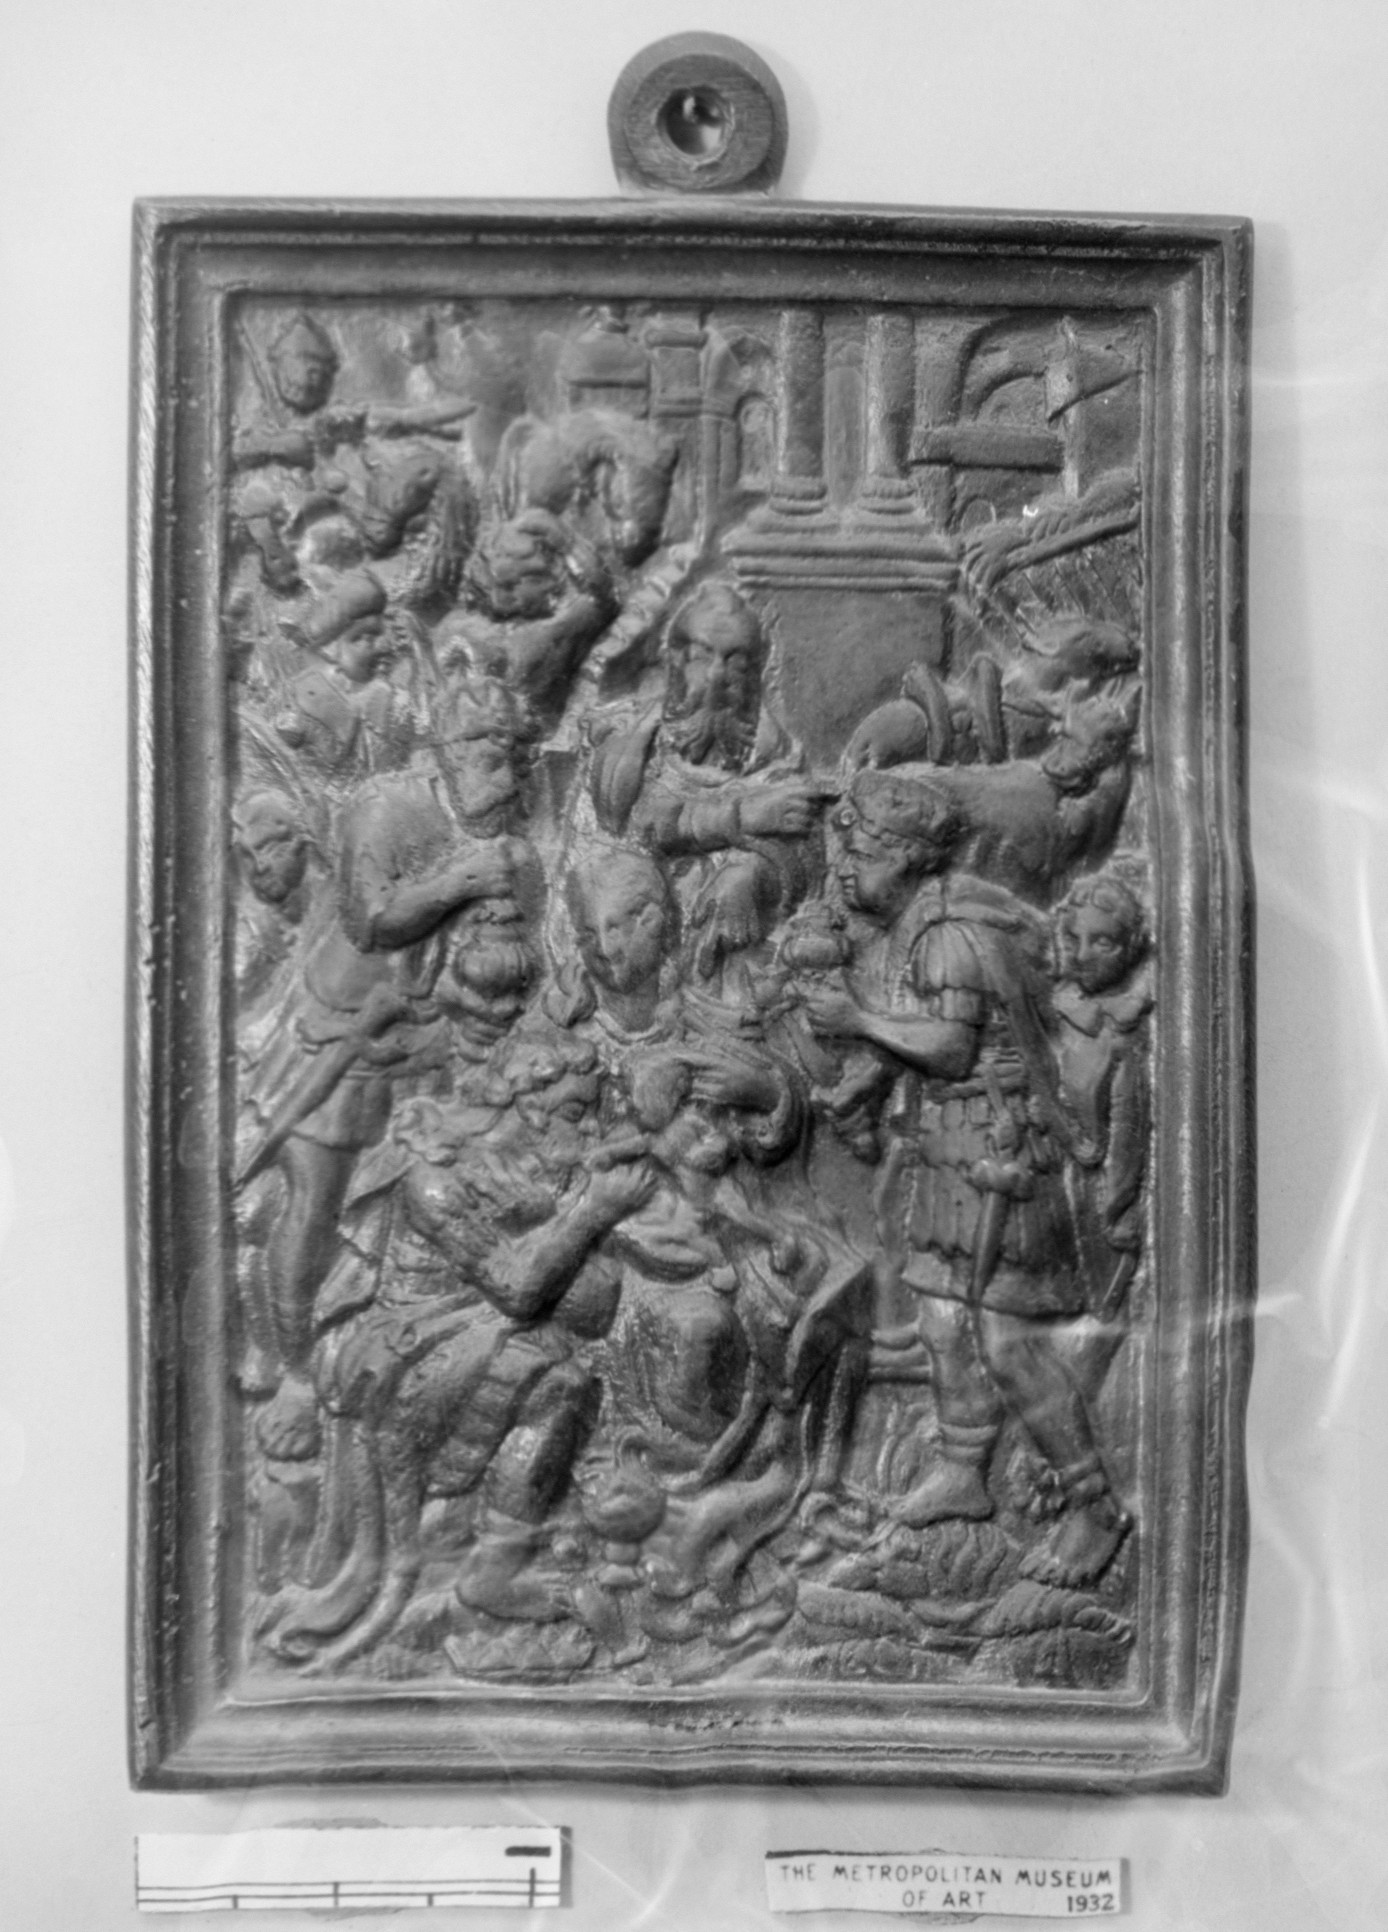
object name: plaquette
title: Adoration of the Magi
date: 1567-1600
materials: bronze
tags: adoration of the magi